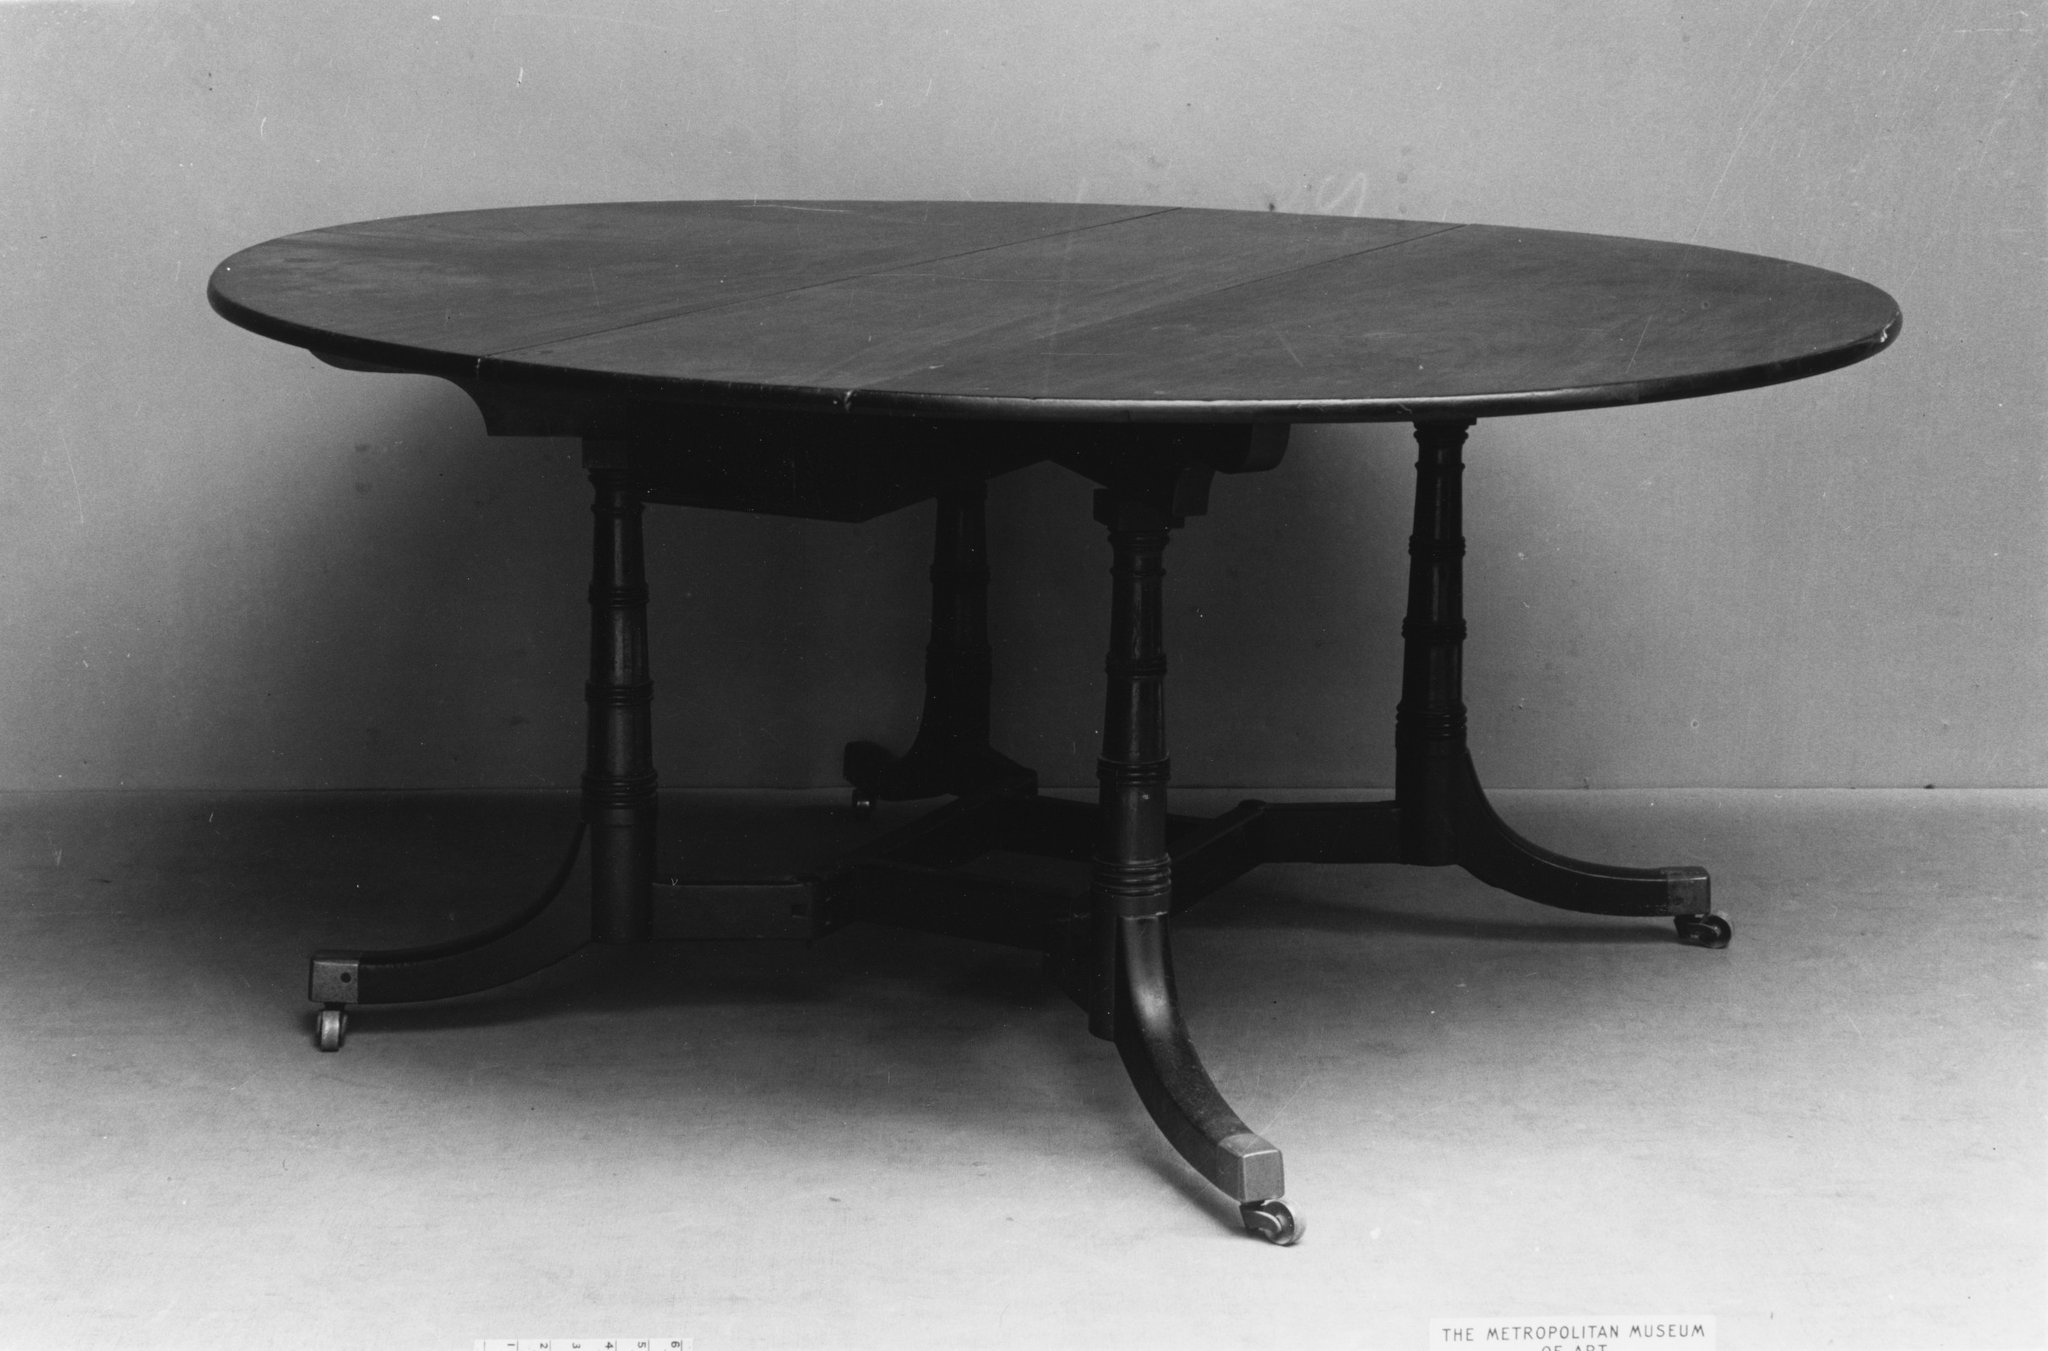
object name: drop leaf table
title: Drop-leaf Table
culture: american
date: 1800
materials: wood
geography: united states